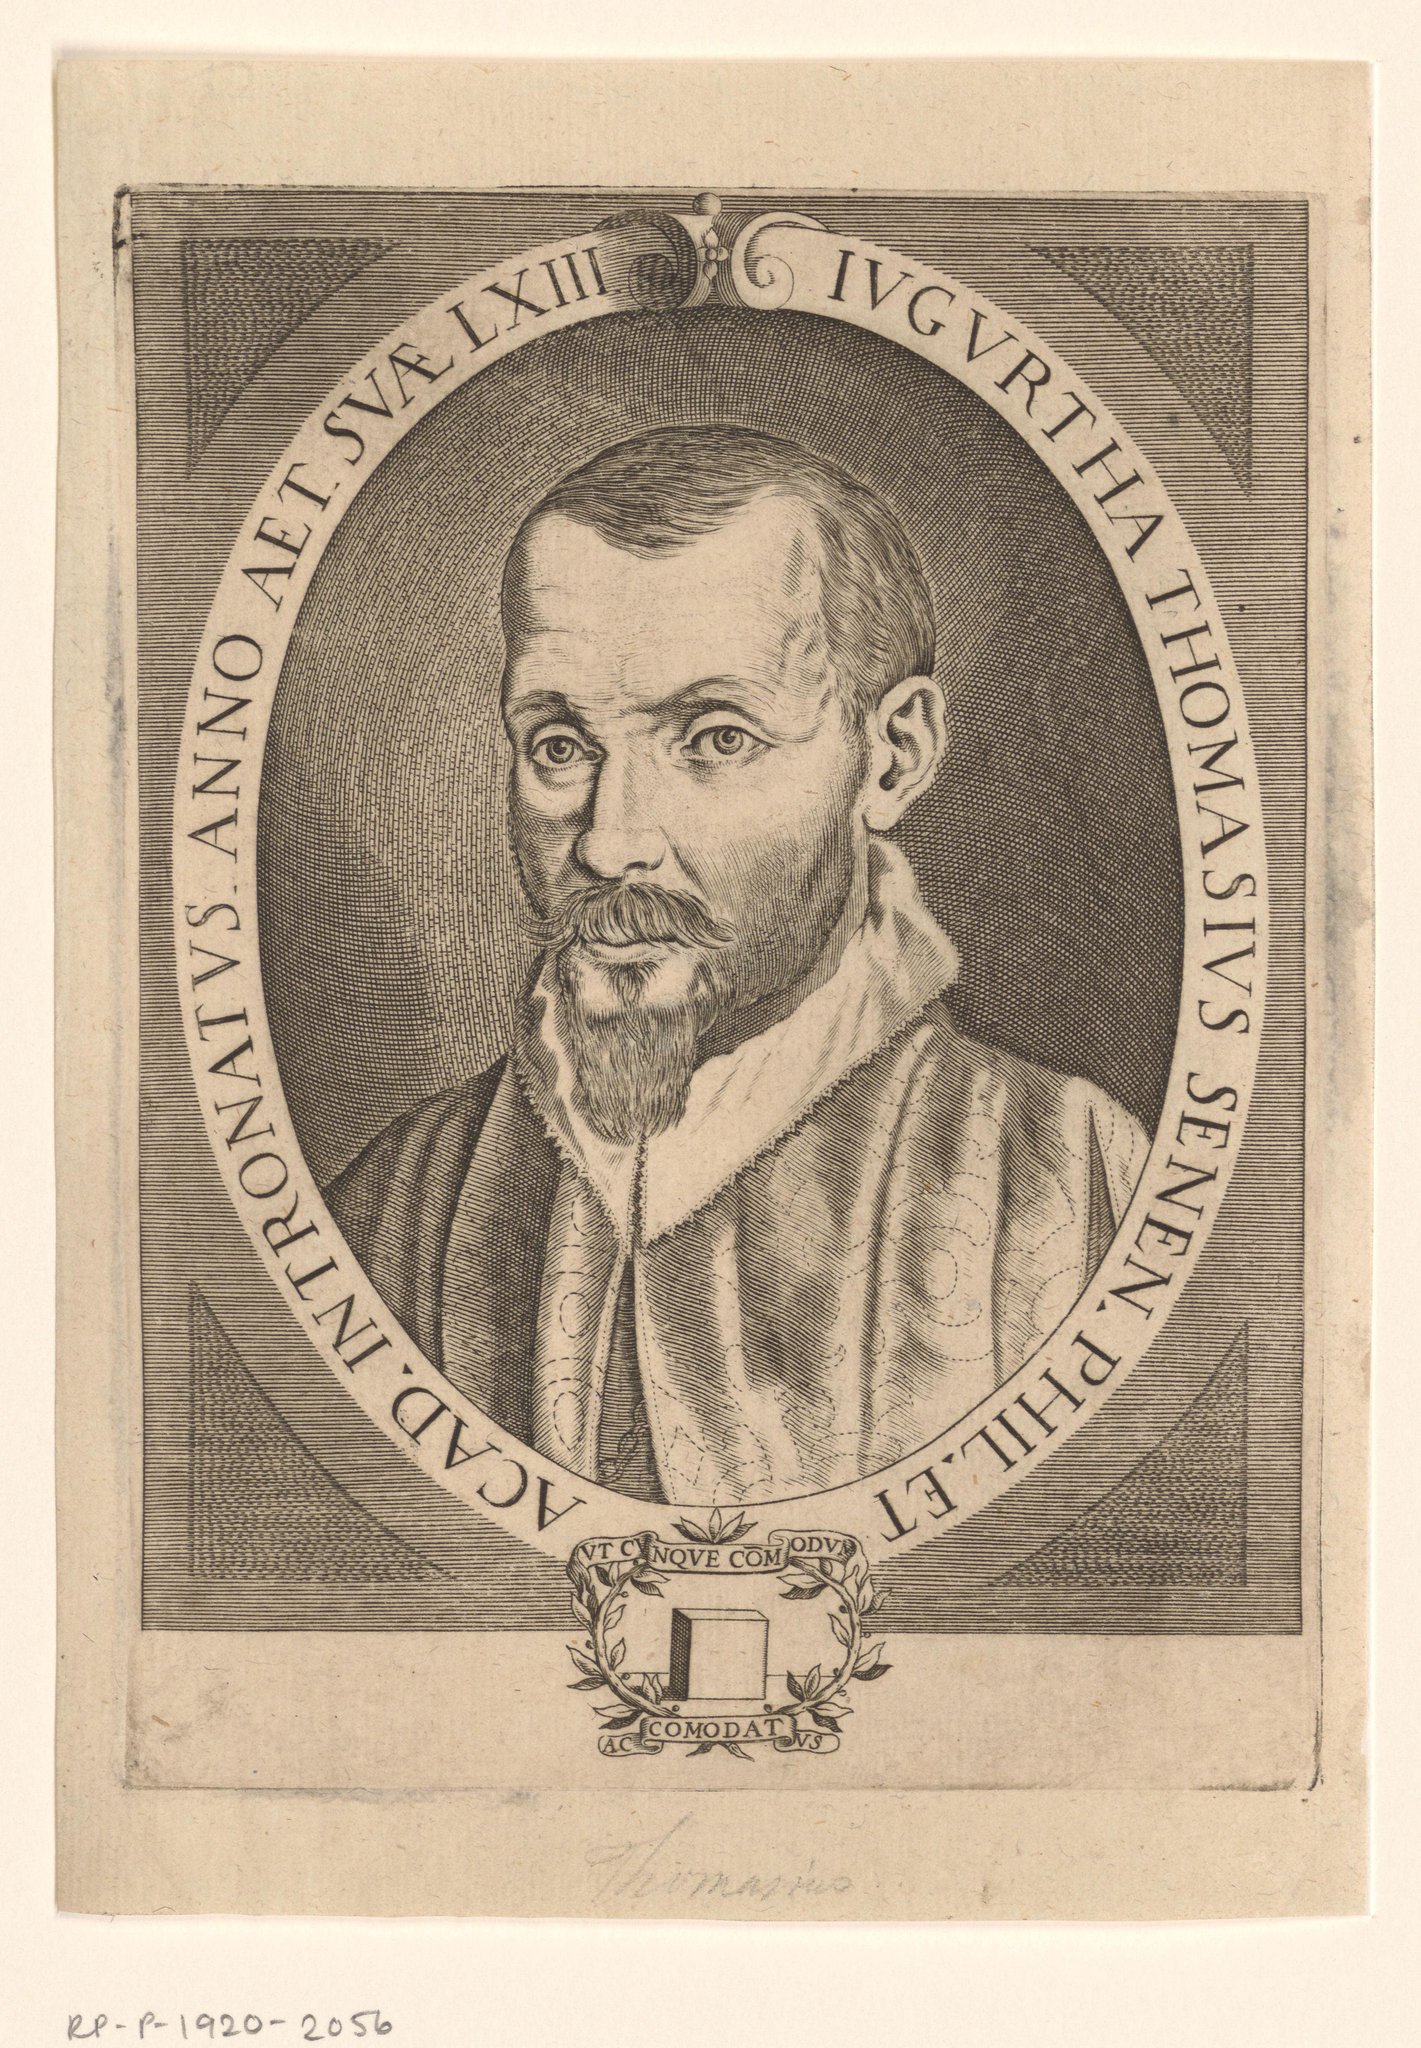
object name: print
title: Portret van Giugurta Tommasi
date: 1625-1626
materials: paper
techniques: engraving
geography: venice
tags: scholar, philosopher, historical persons, portrait of a writer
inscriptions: collector's mark: Lugt 2228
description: Prent uit: Tommasi, Giugurta. Dell'historie di Siena. Venetië: Giovanni Battista Pulciani, 1625-1626.